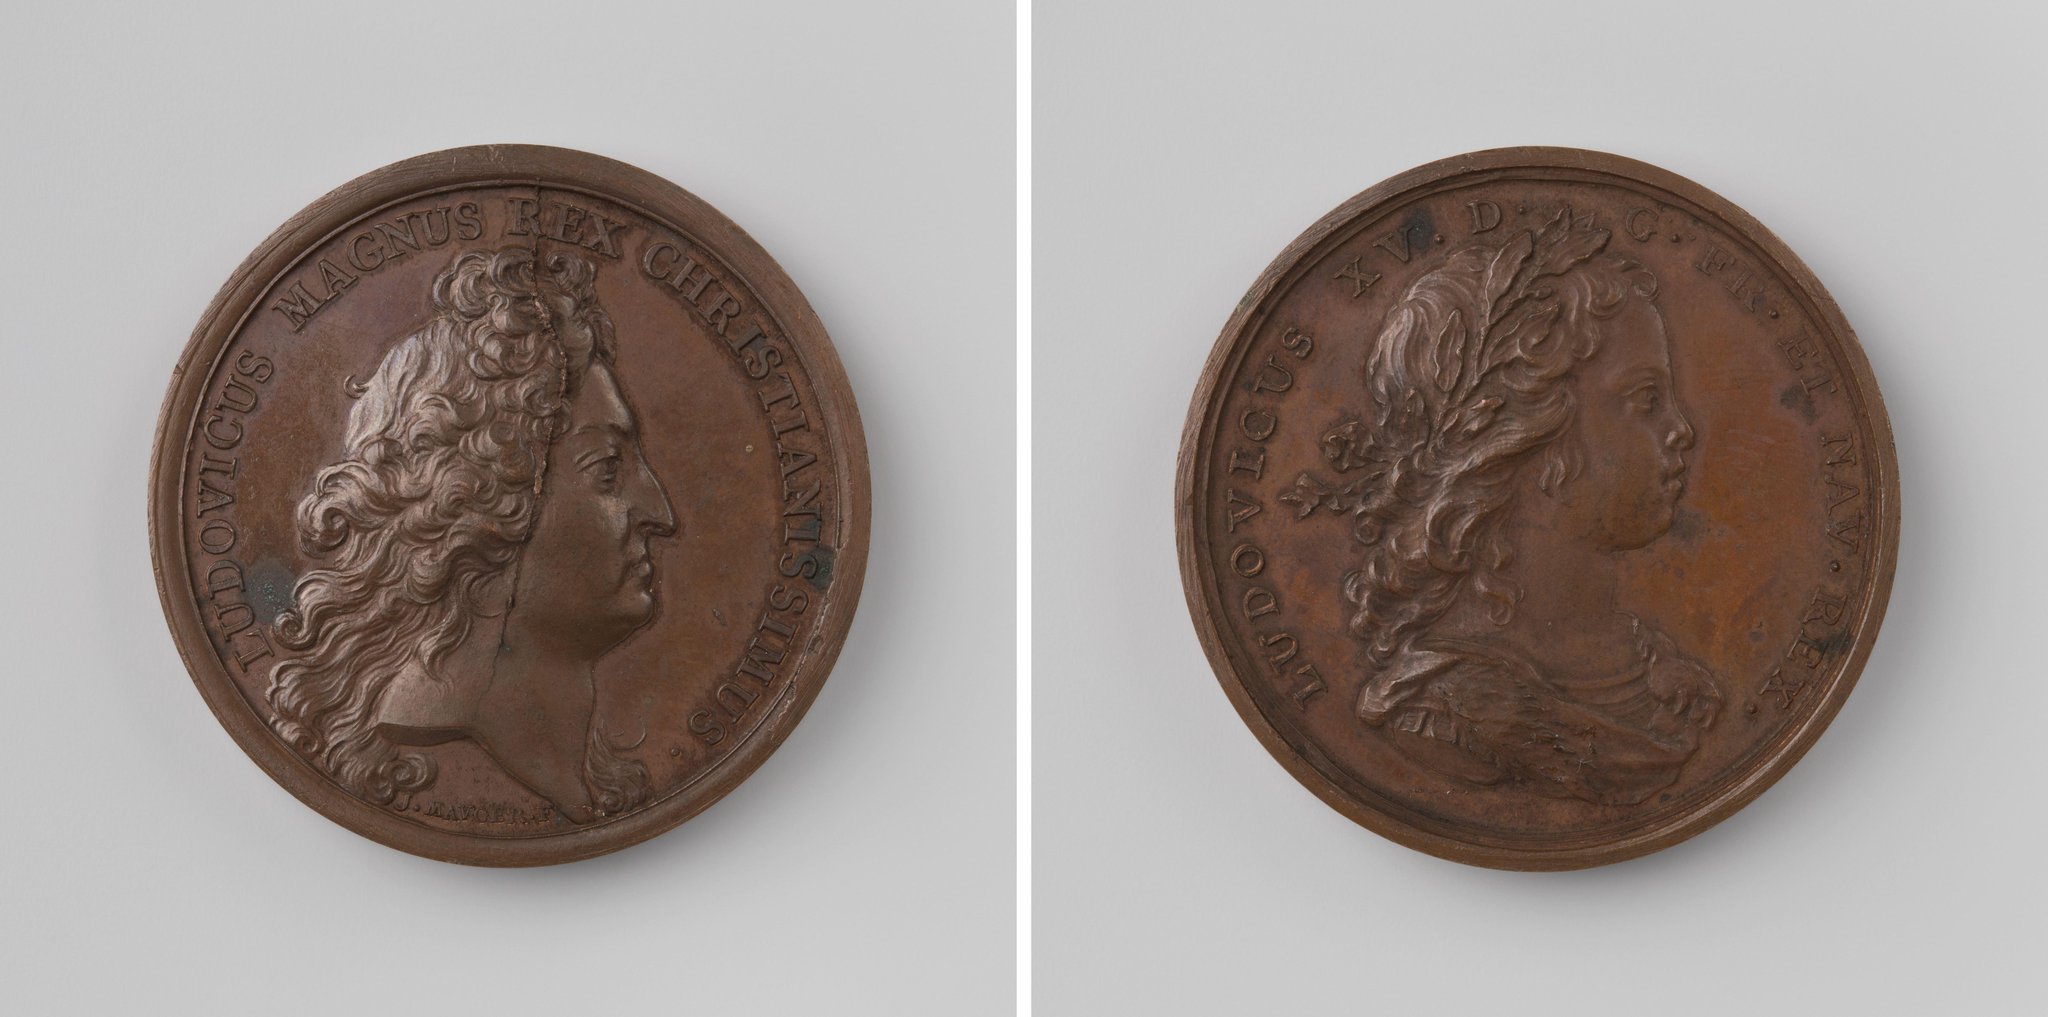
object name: history medal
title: Ter ere van Lodewijk XIV, koning van Frankrijk en zijn opvolger Lodewijk XV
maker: jean mauger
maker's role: medailleur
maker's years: 1648-1722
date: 1715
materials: bronze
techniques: striking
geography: paris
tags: lodewijk xiv (koning van frankrijk), louis xv of france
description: Bronzen penning. Voorzijde: borststuk man binnen omschrift. Keerzijde: borstsuk jongen met lauwerkrans binnen omschrift